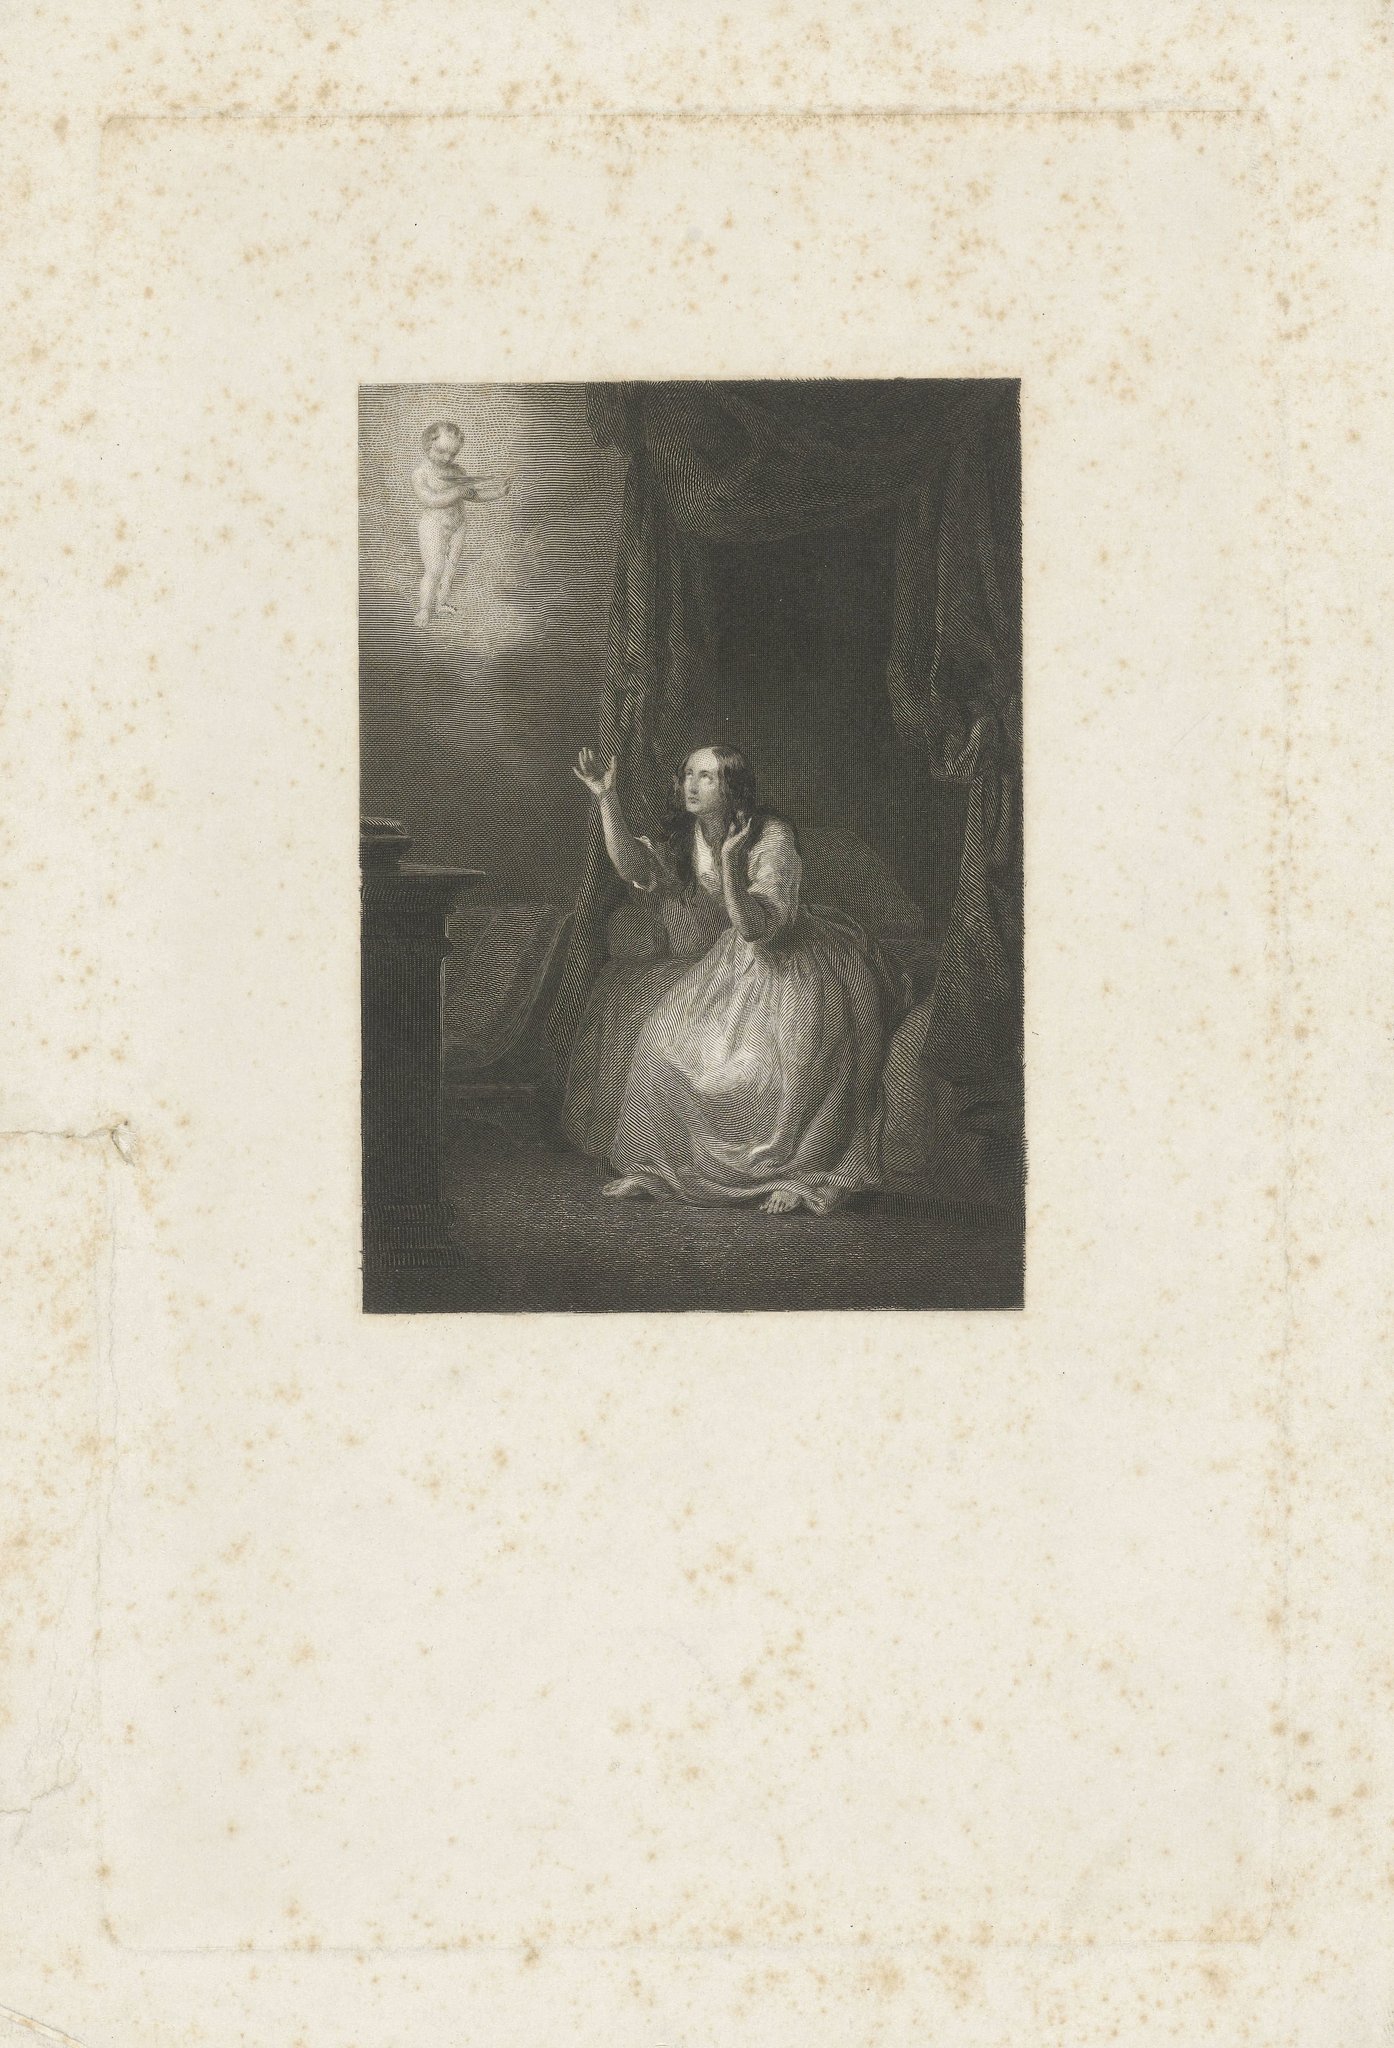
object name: print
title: Een jonge vrouw heeft een visioen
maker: johann wilhelm kaiser (i)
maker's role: draughtsman, print maker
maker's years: 1813-1900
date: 1849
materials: paper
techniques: engraving, etching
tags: bed, vision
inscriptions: collector's mark: Lugt 2228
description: Illustratie voor het tijdschrift: Bergh, S.J. van den, Jaarboek Aurora, Den Haag: Koenraad Fuhri, 1840-1877, 1852.